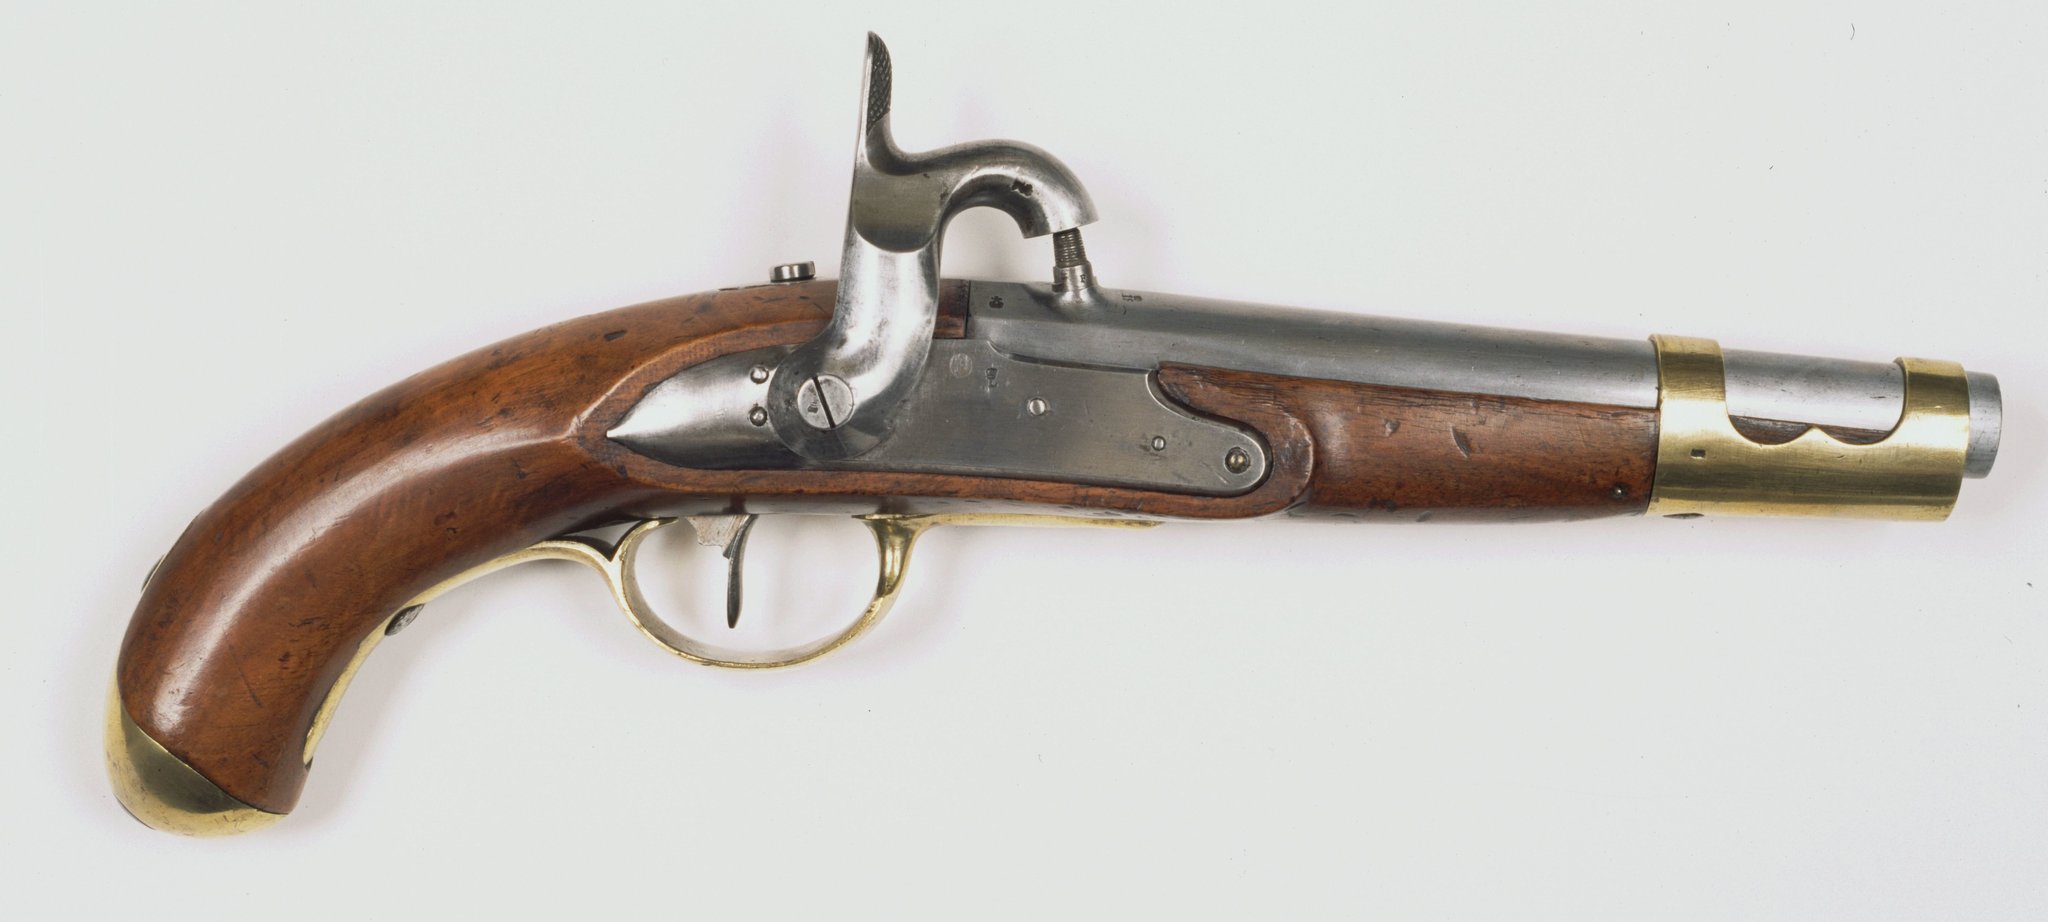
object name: percussion pistol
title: Percussie legerpistool model M 1815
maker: Anonymous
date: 1815-1816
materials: brass, iron, wood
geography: netherlands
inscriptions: signature: ‘K met kroon’, signature: ‘IS met kroon’, signature: ‘L met kroon’